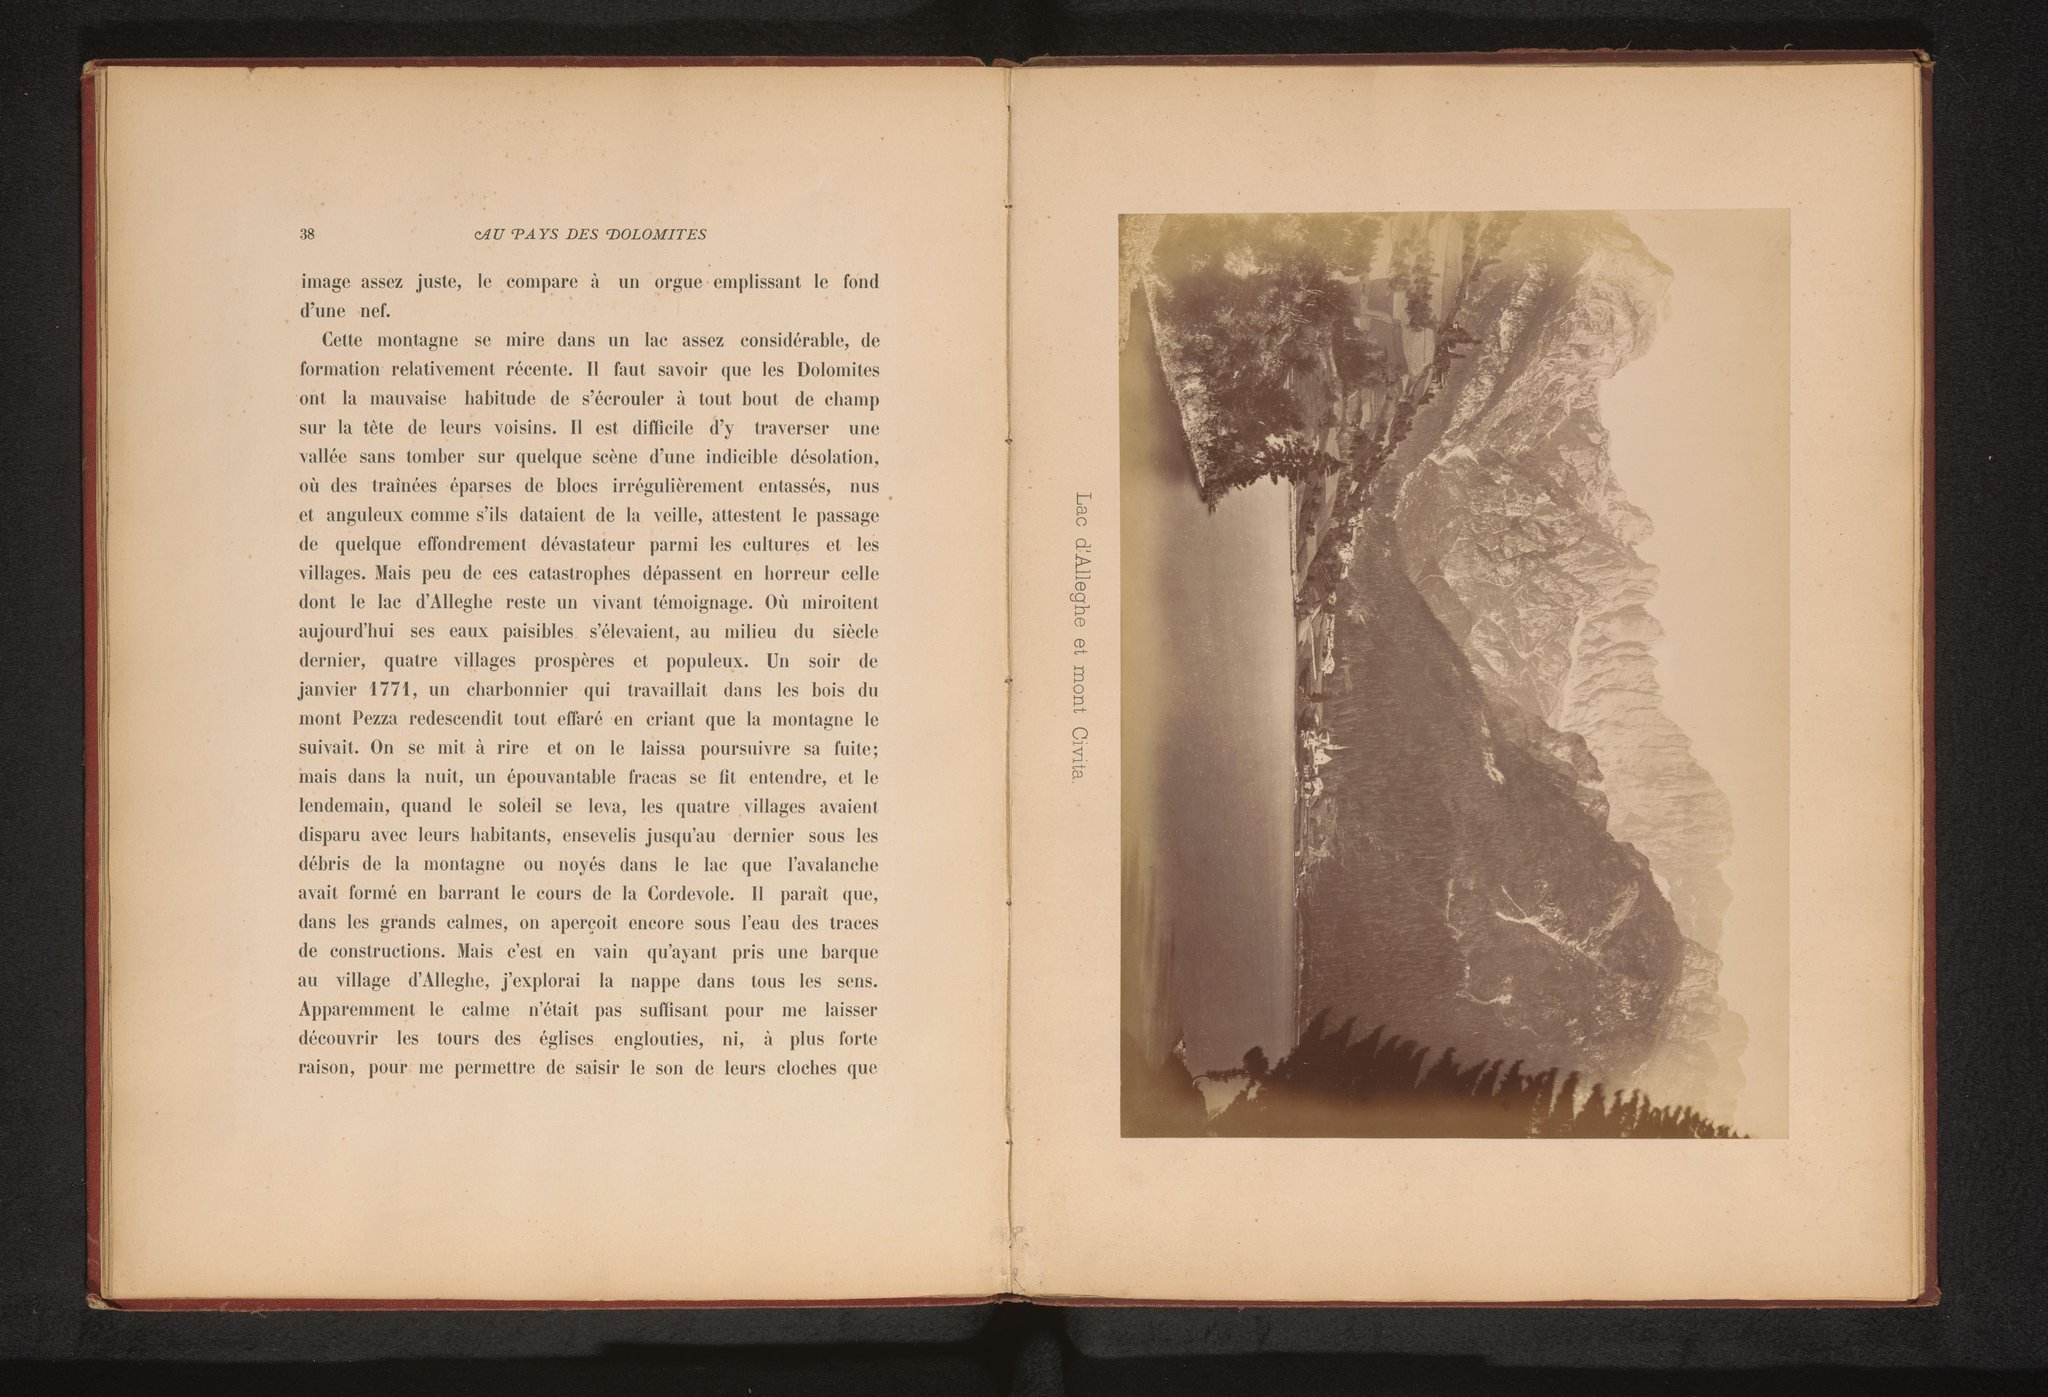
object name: photograph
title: Lac d'Alleghe et mont Civita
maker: eugène goblet dalviella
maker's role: politician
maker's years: 1846-1925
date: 1873-1878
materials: photographic support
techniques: albumen print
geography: dolomites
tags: prospect of village, silhouette of village, lake, mountains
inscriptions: number: ‘9[...]’